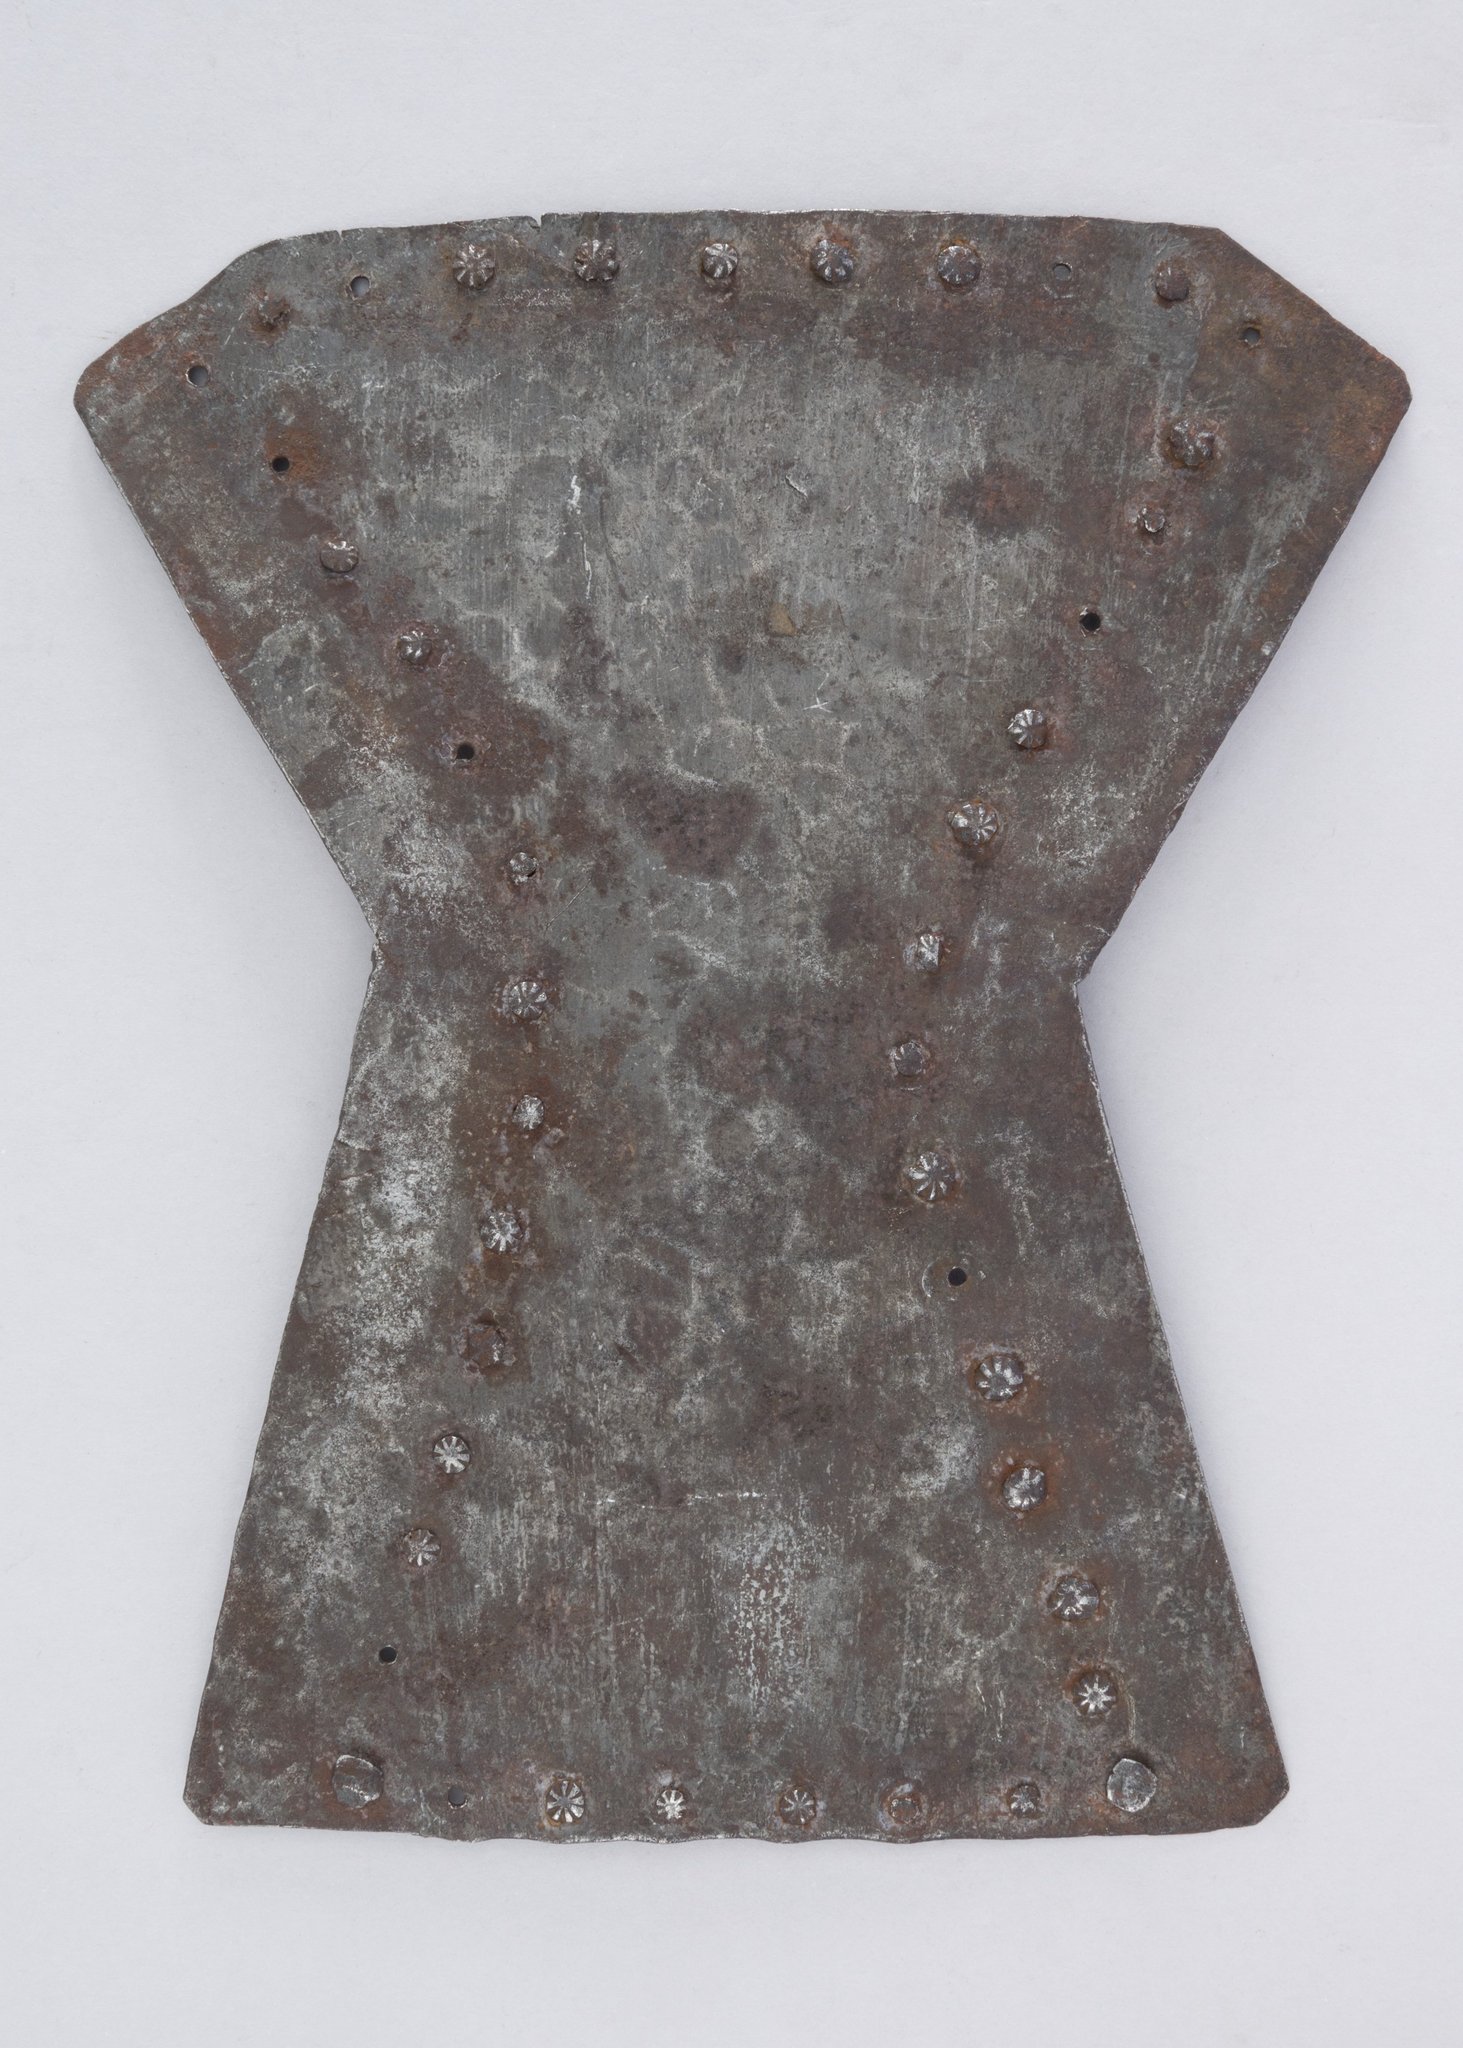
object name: brigandine plate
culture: italian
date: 1400-1450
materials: metal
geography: italy